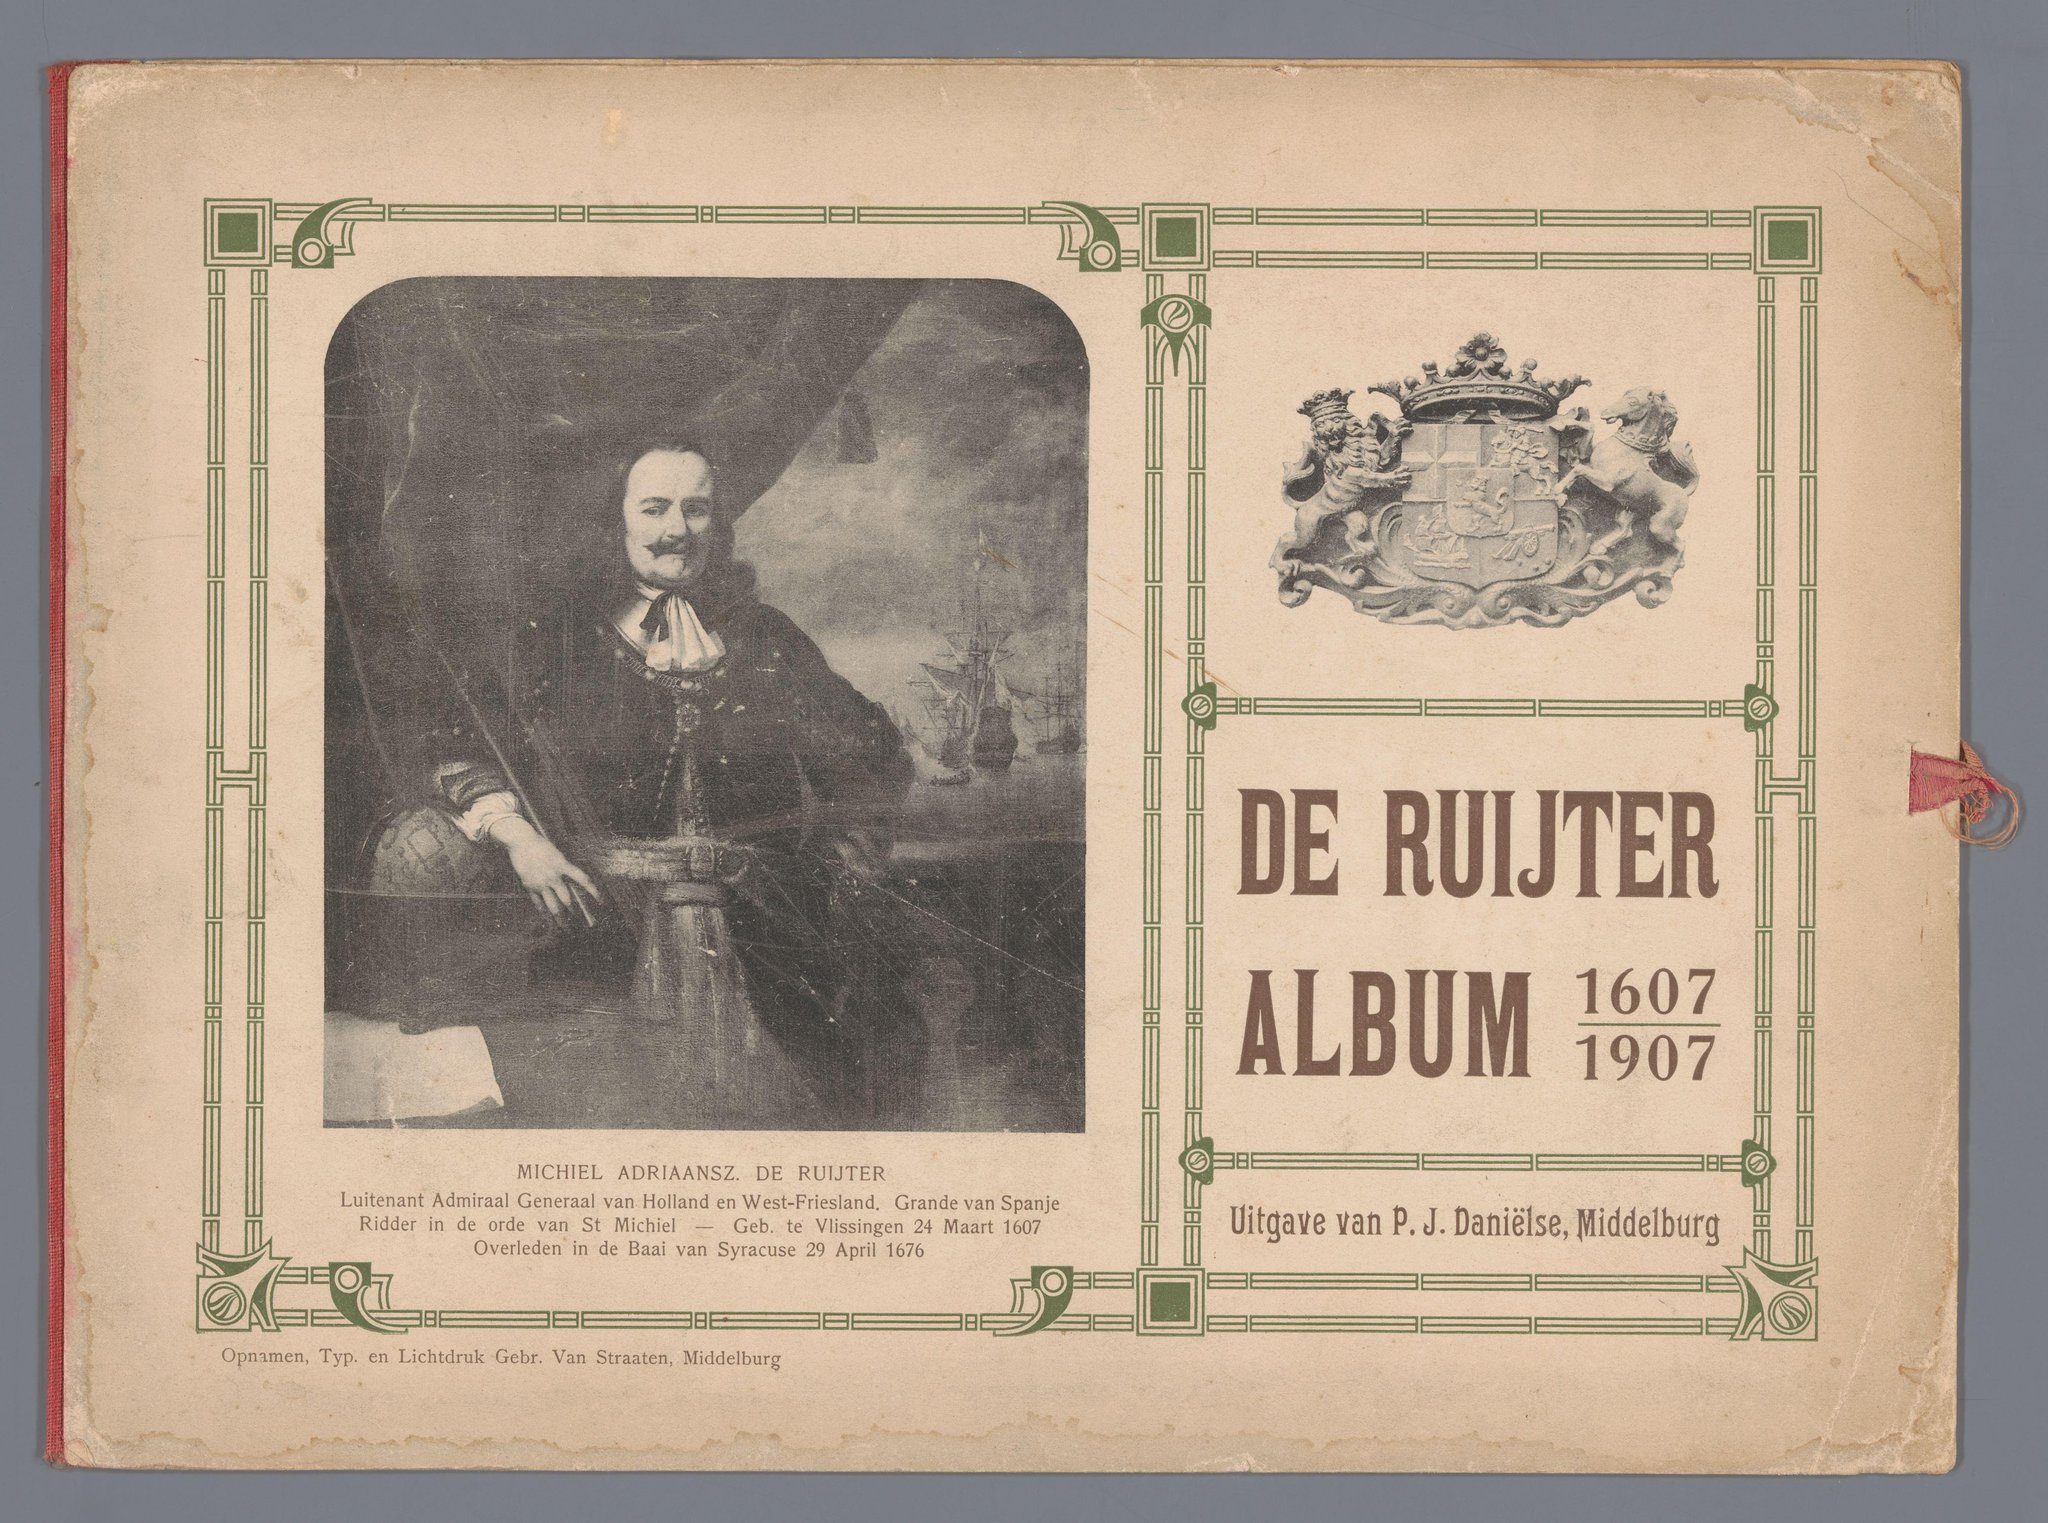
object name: album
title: De Ruijter Album, 1607 - 1907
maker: p.j. daniëlse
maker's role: publisher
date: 1907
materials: cardboard, paper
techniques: photography, printing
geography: middelburg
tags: flushing, michiel adriaenszoon de ruyter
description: Kartonnen omslag met rode linnen rug, waarin, elk op grijs papier geplakt, 12 genummerde foto's.